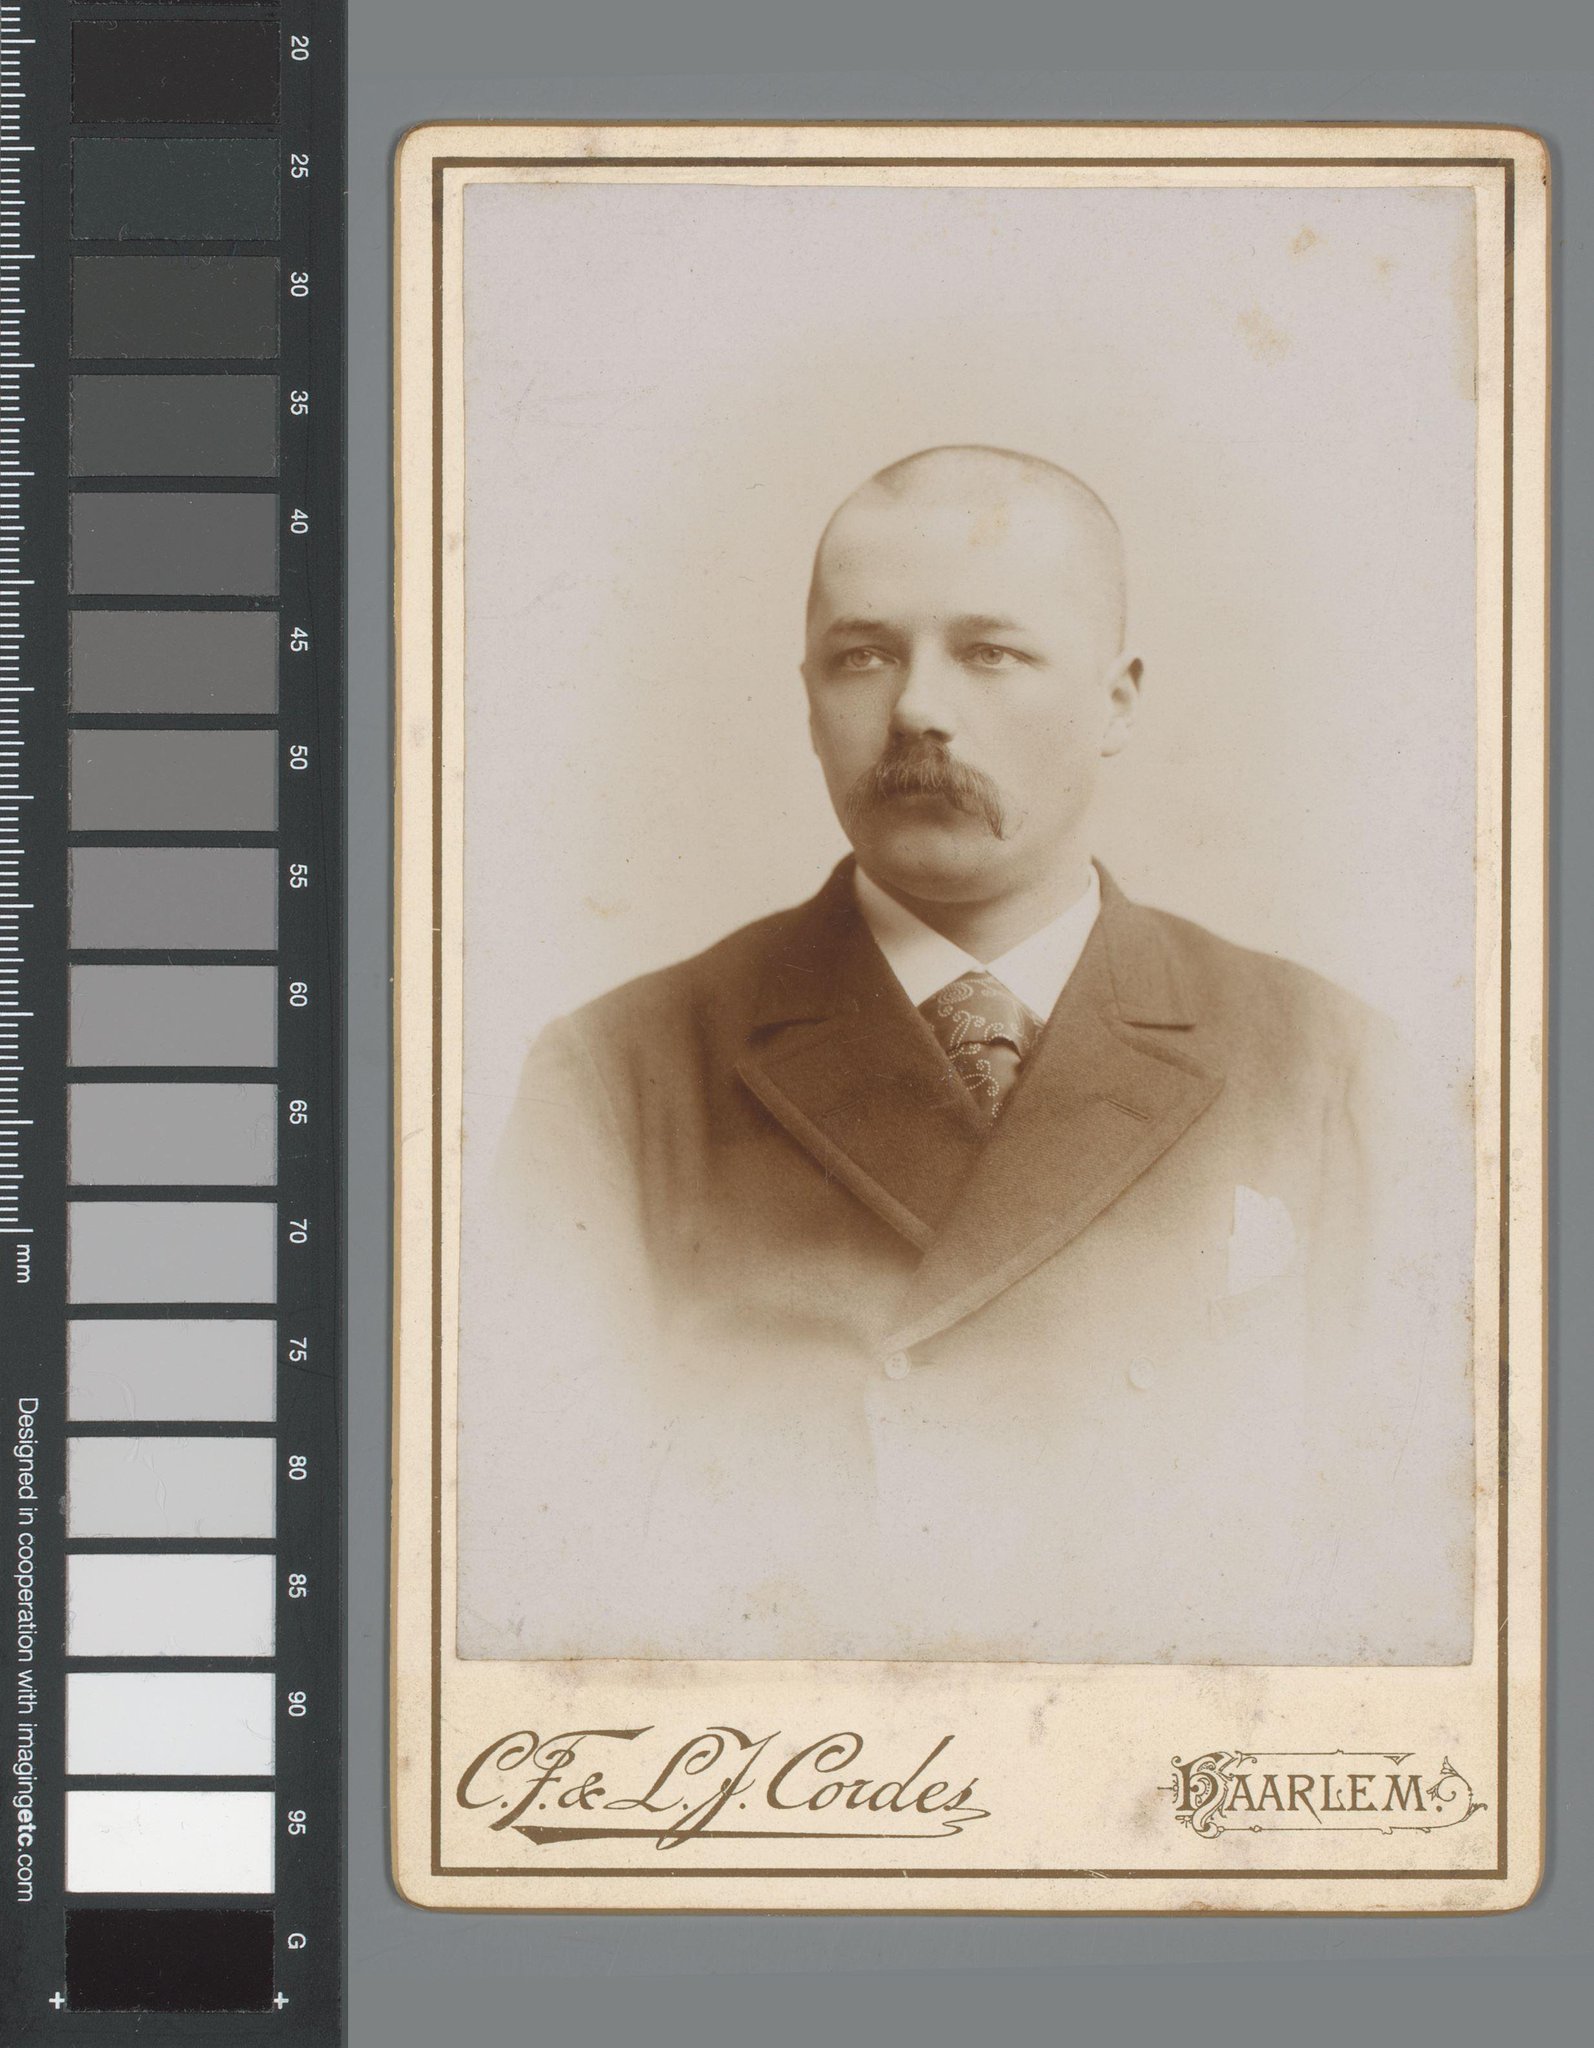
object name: cabinet photograph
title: Portret van Lucas Jonker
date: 1870-1920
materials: cardboard, photographic support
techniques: gelatin silver print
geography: haarlem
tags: historical persons, haarlem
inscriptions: workshop stamp: ‘C.F. & LJ. Cordes/ Haarlem, Groote Houtstraat 84/ 's Bosch a/d. Parade’, inscription: ‘Lucas Jonker’